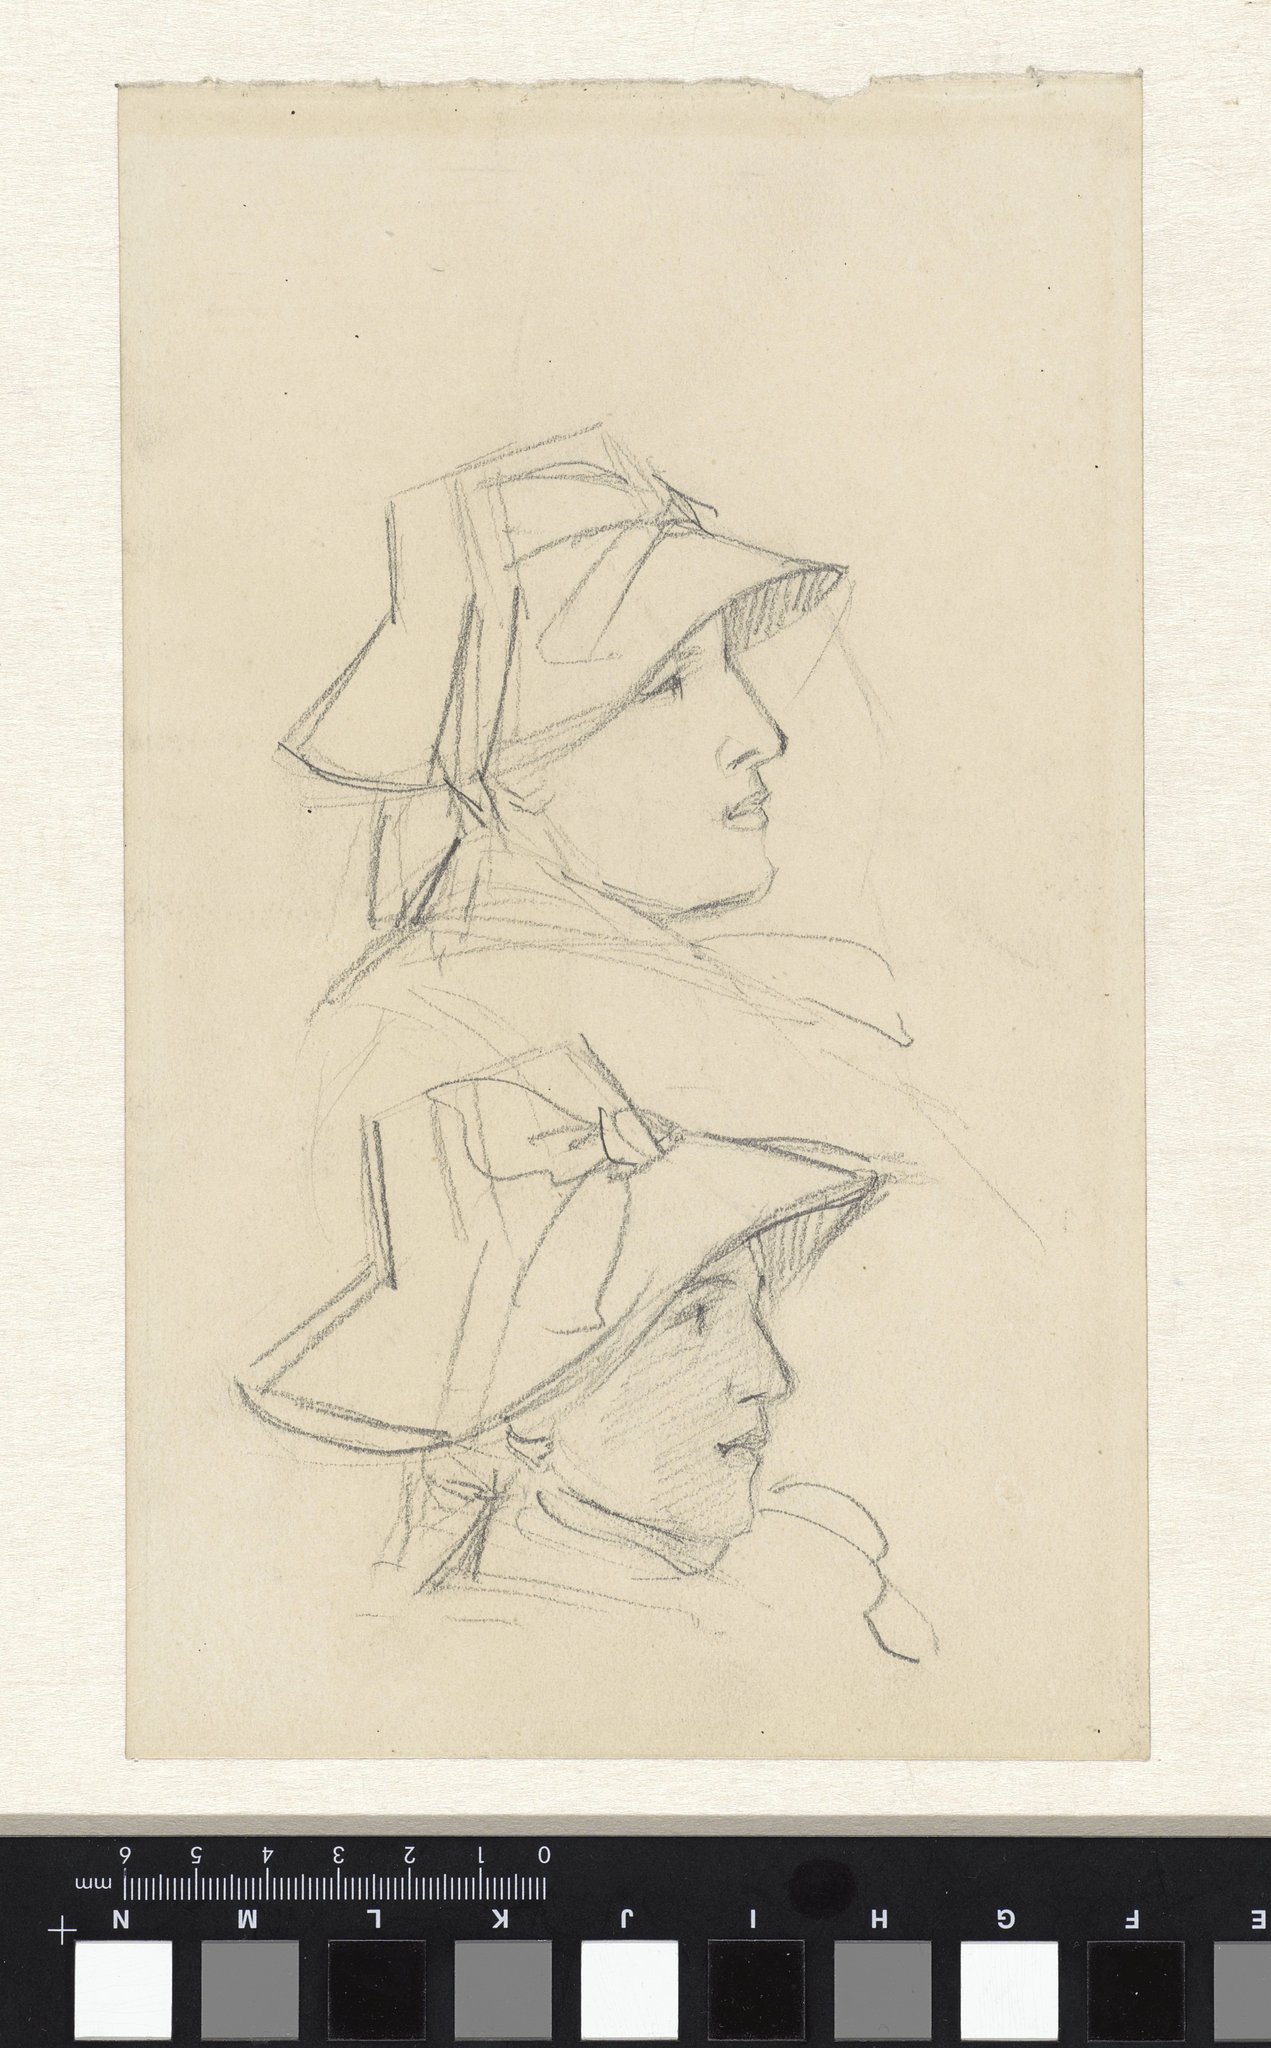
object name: drawing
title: Twee studies van een vrouw met een hoed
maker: jozef israëls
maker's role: draughtsman, painter, print maker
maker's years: 1824-1911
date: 1834-1911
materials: paper, pencil